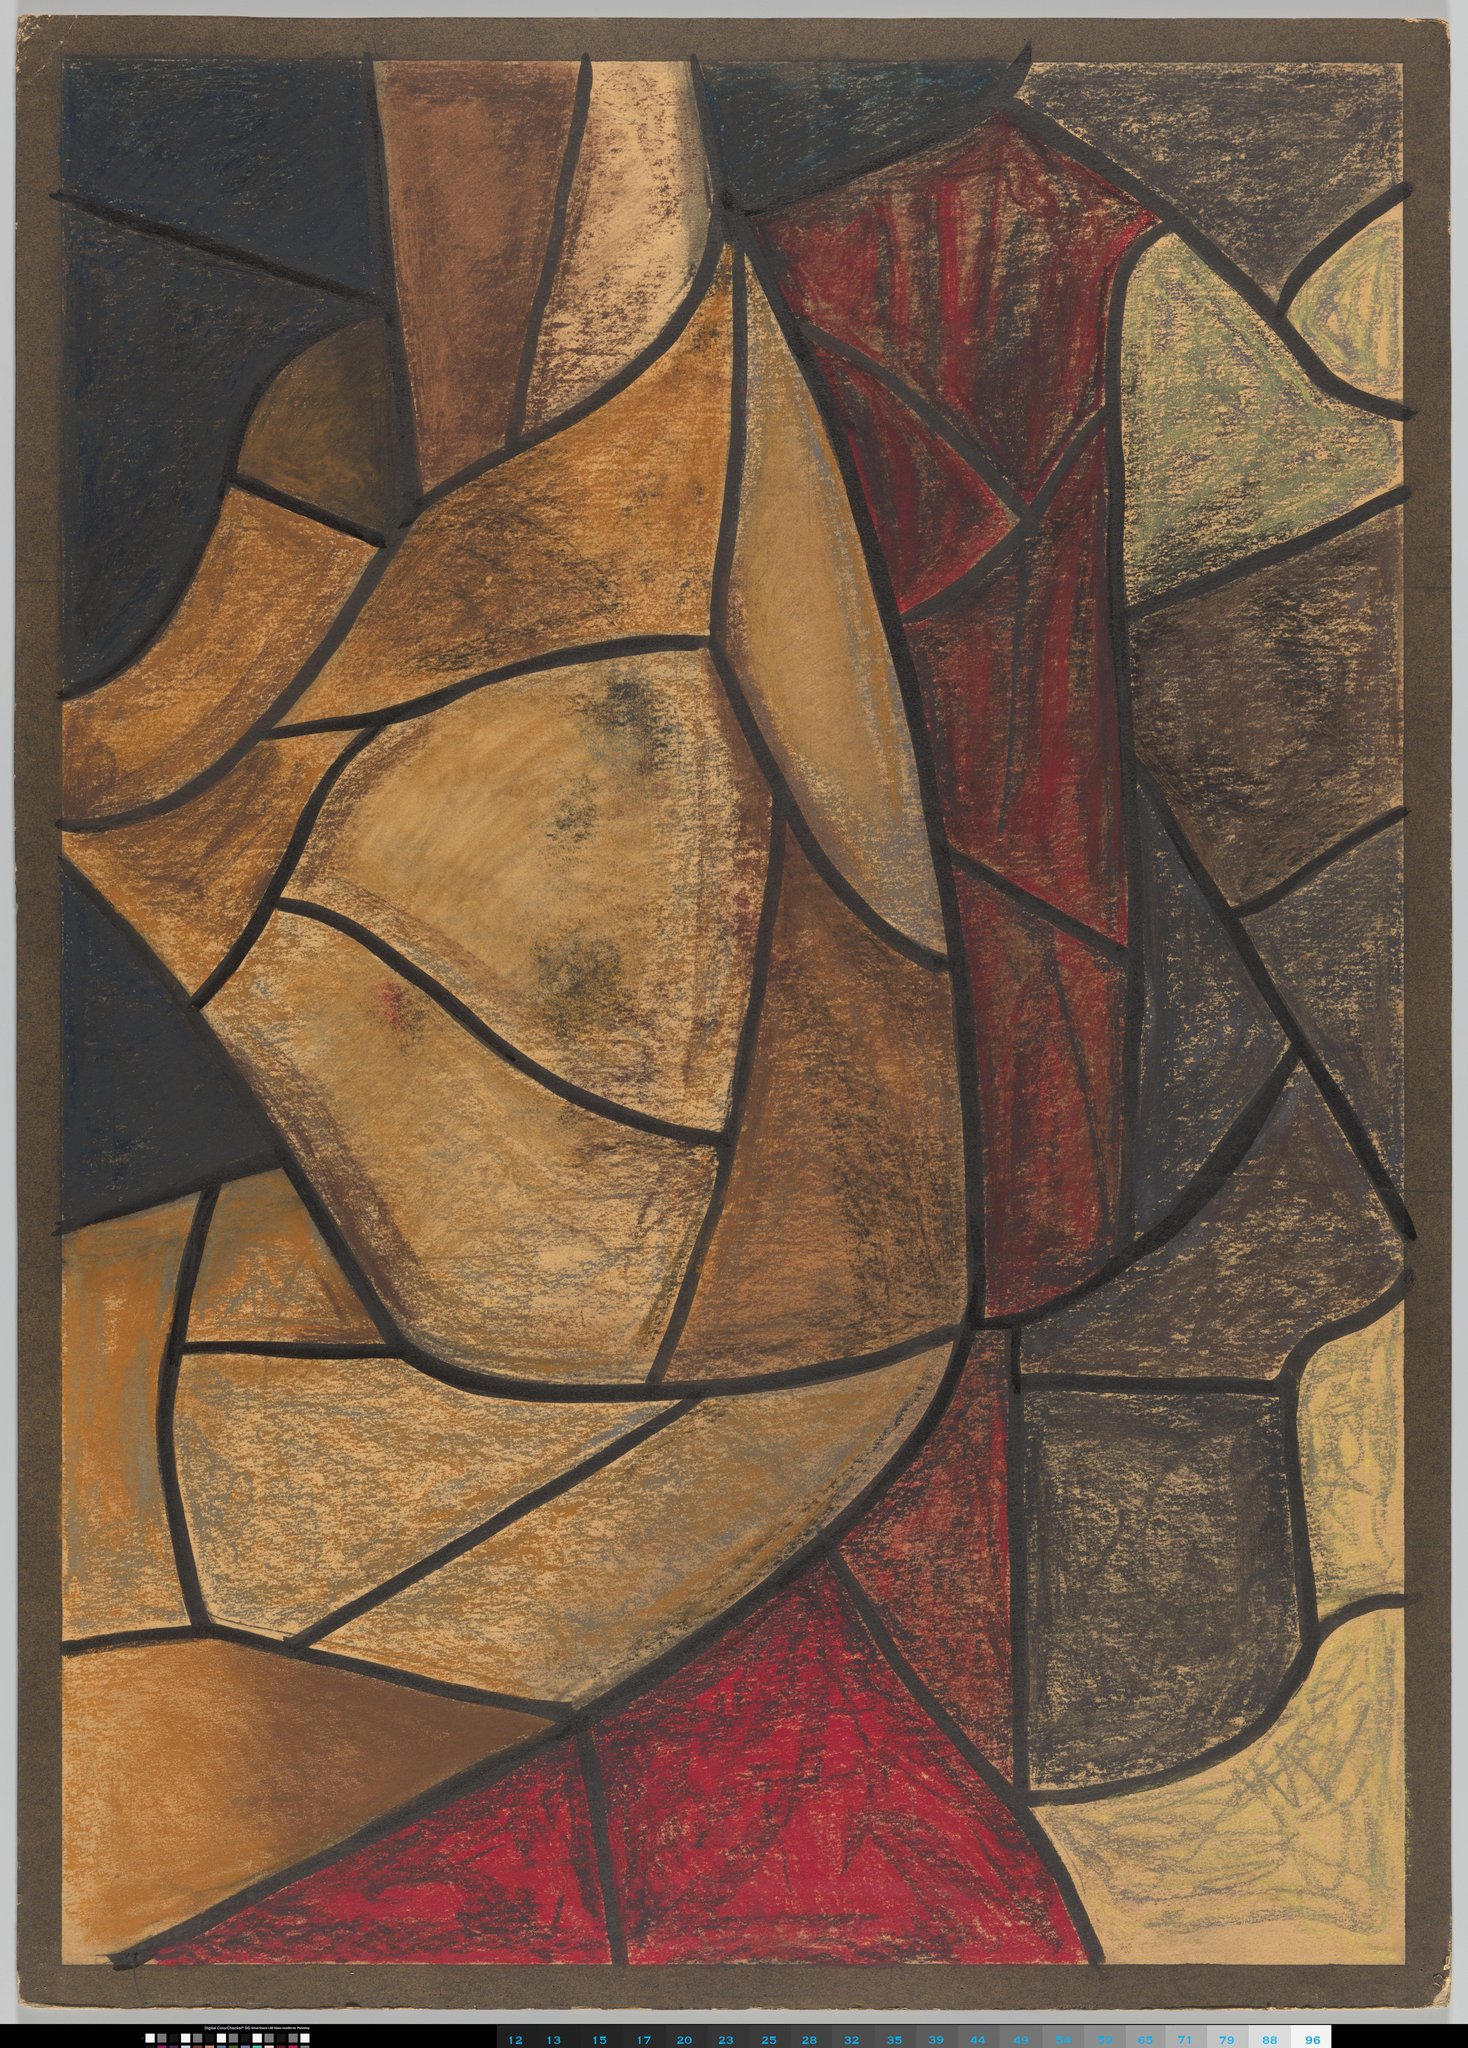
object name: drawing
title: Ontwerp voor raam in het Noordertransept in de Dom te Utrecht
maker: richard nicolaüs roland holst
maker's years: 1868-1938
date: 1934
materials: cardboard, chalk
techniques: brush